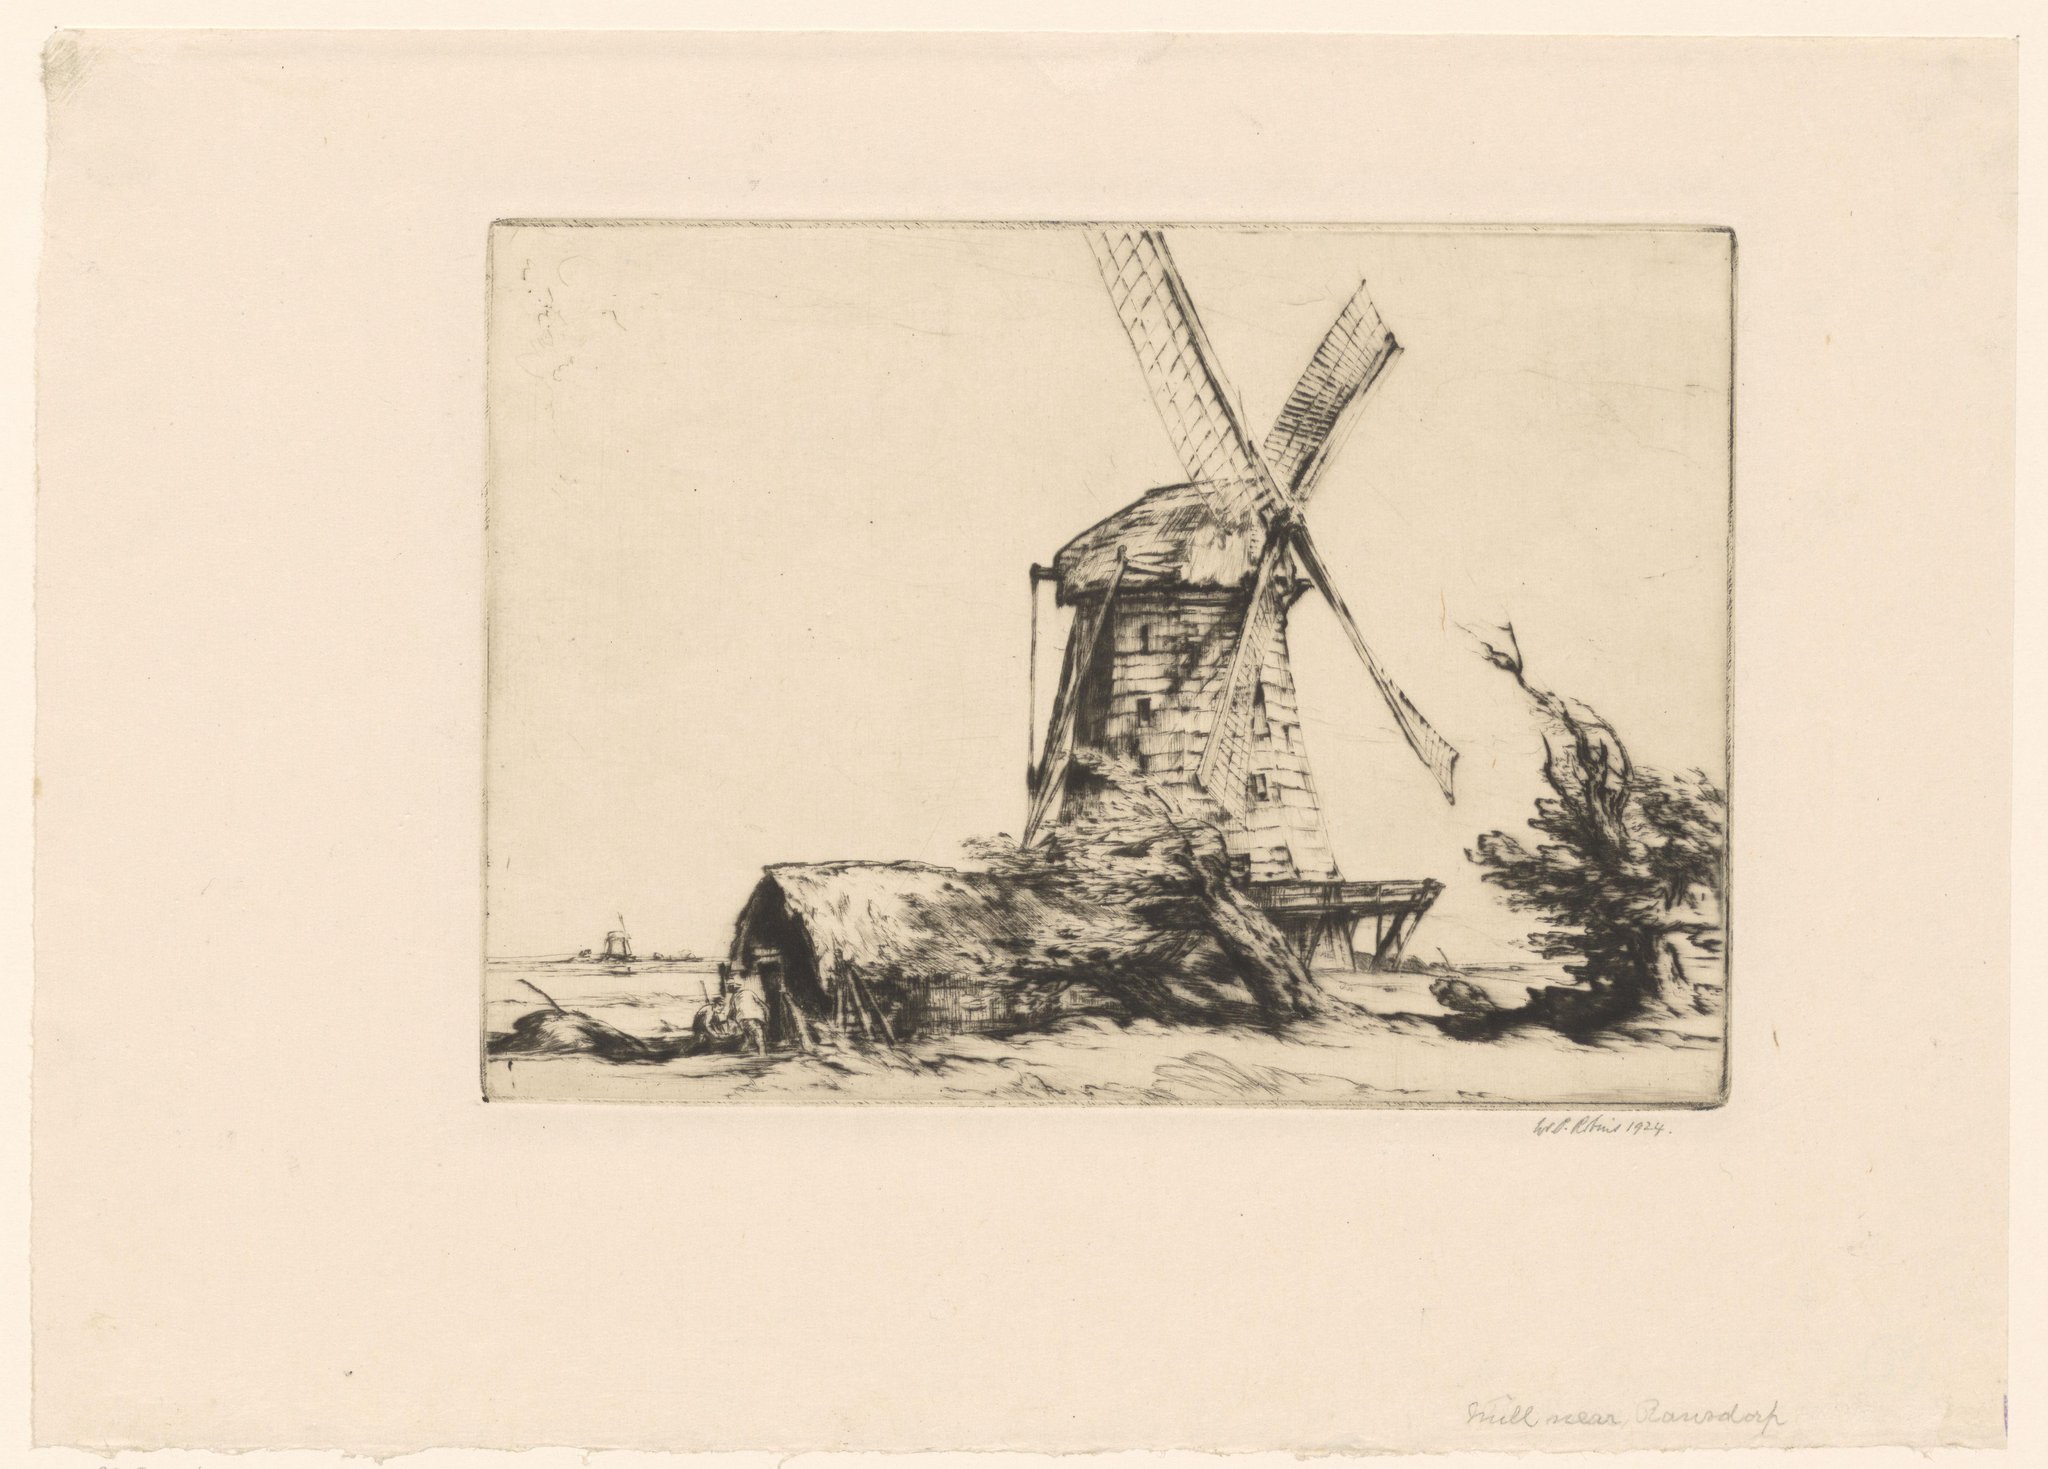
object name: print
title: Mill near Ransdorp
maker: william palmer robins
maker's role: print maker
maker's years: 1882-1959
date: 1924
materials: paper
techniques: drypoint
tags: windmill in landscape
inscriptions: collector's mark: Lugt 2760, collector's mark: Lugt 5101, collector's mark: Lugt 2228